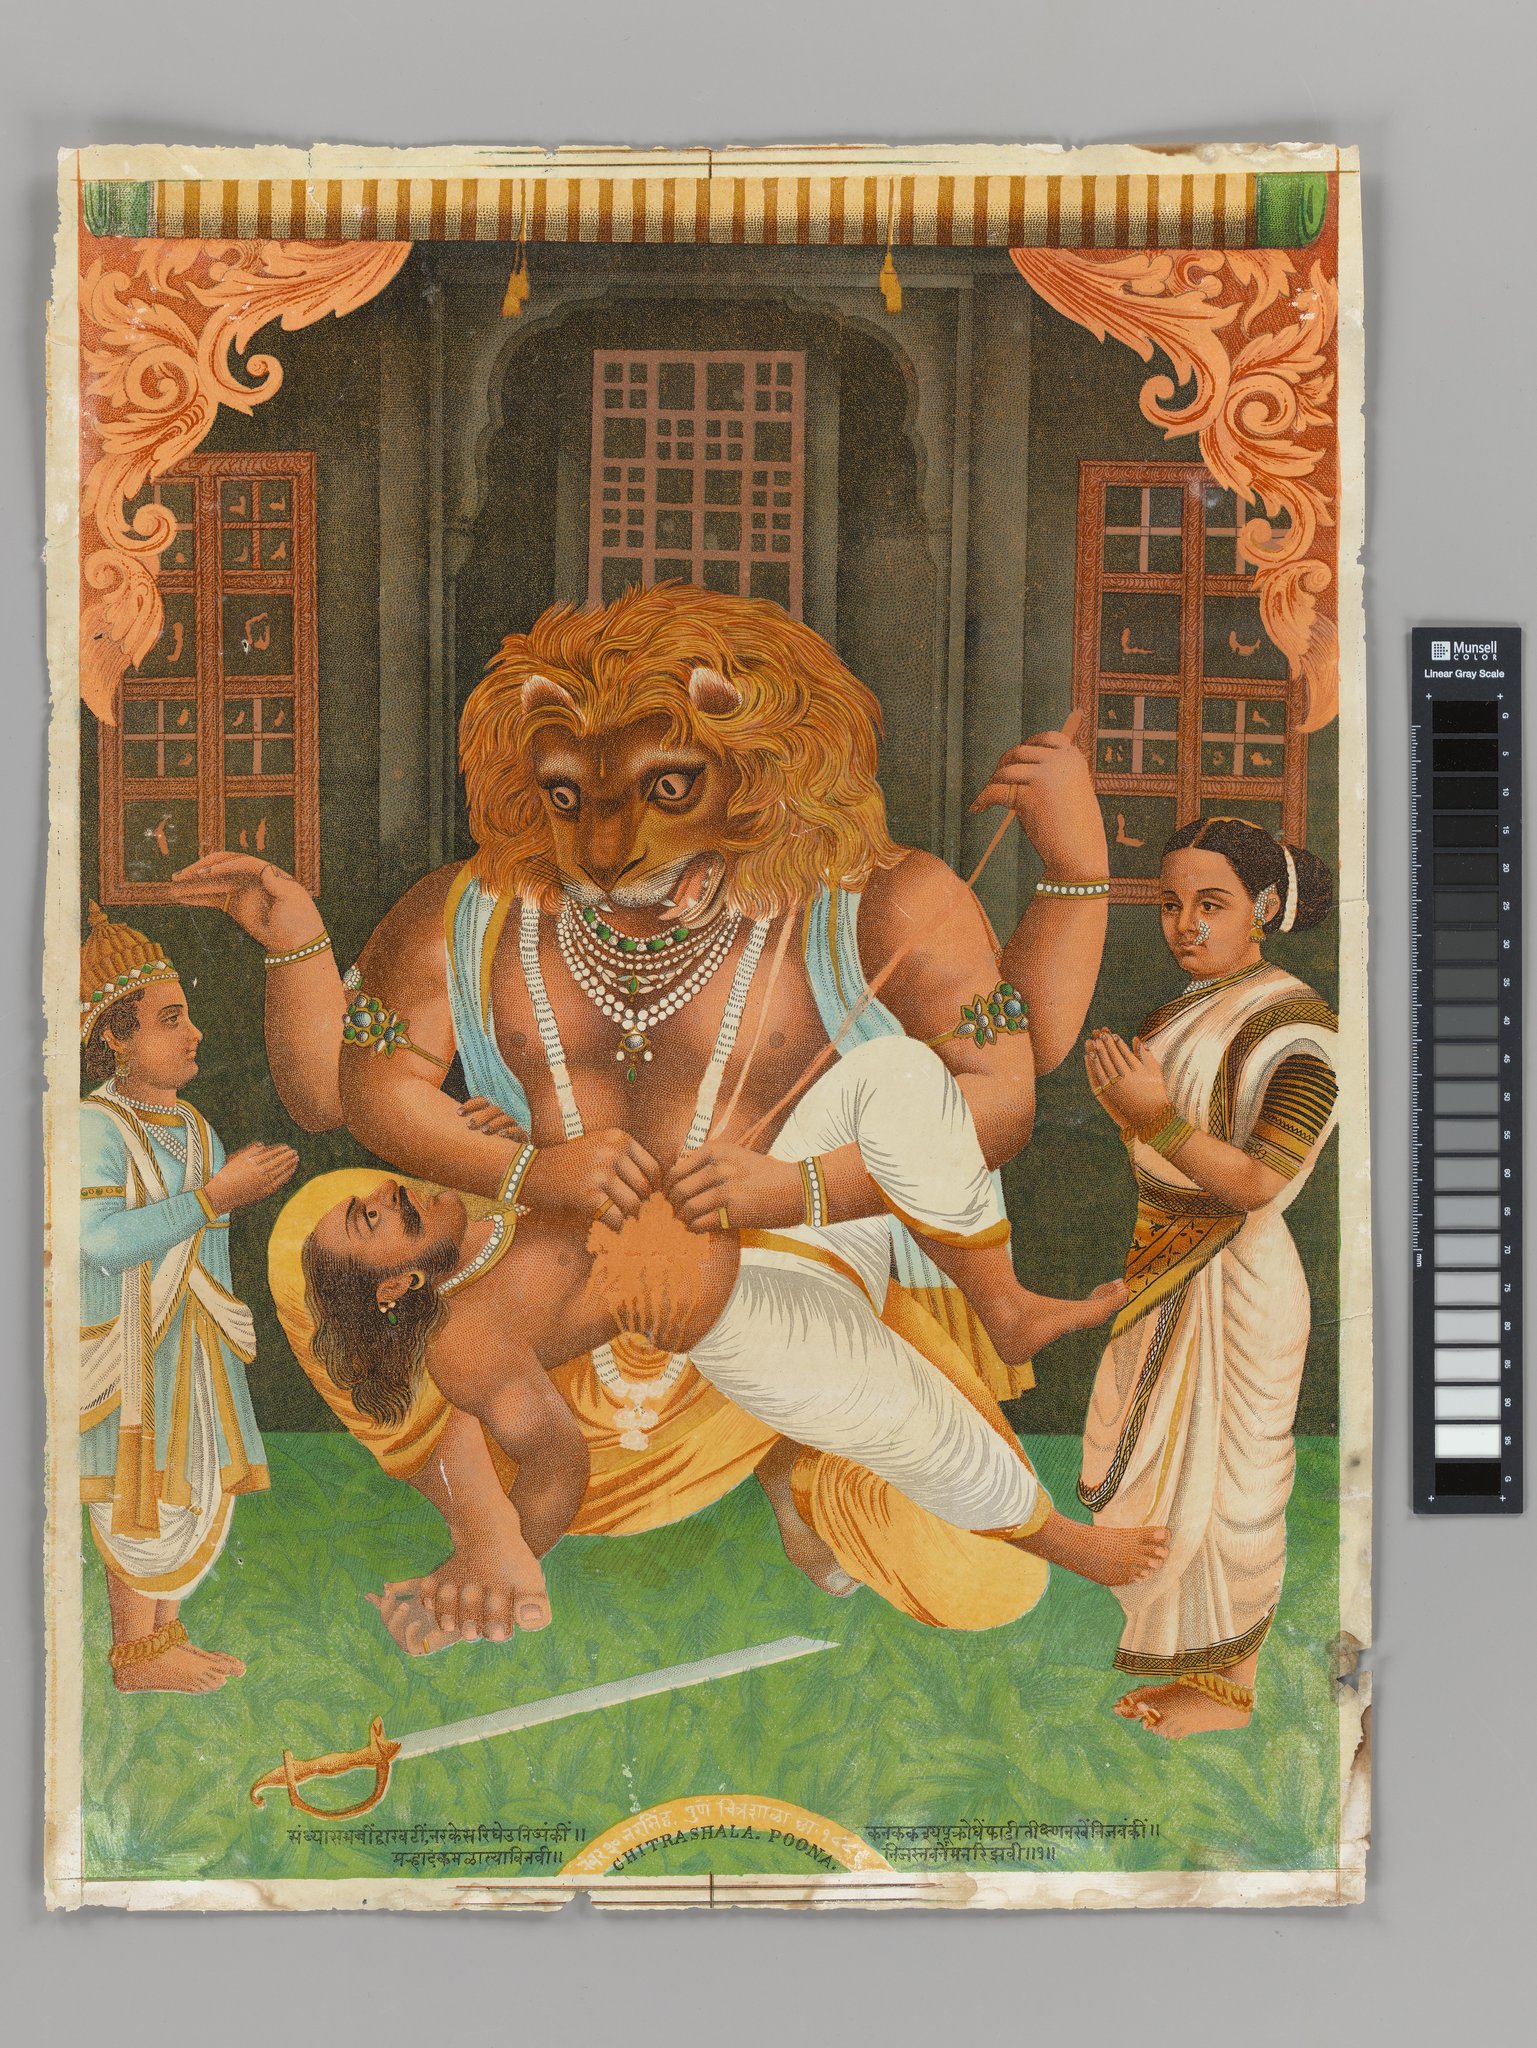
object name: print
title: Narasimha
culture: indian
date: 1886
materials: chromolithograph, paper, varnish